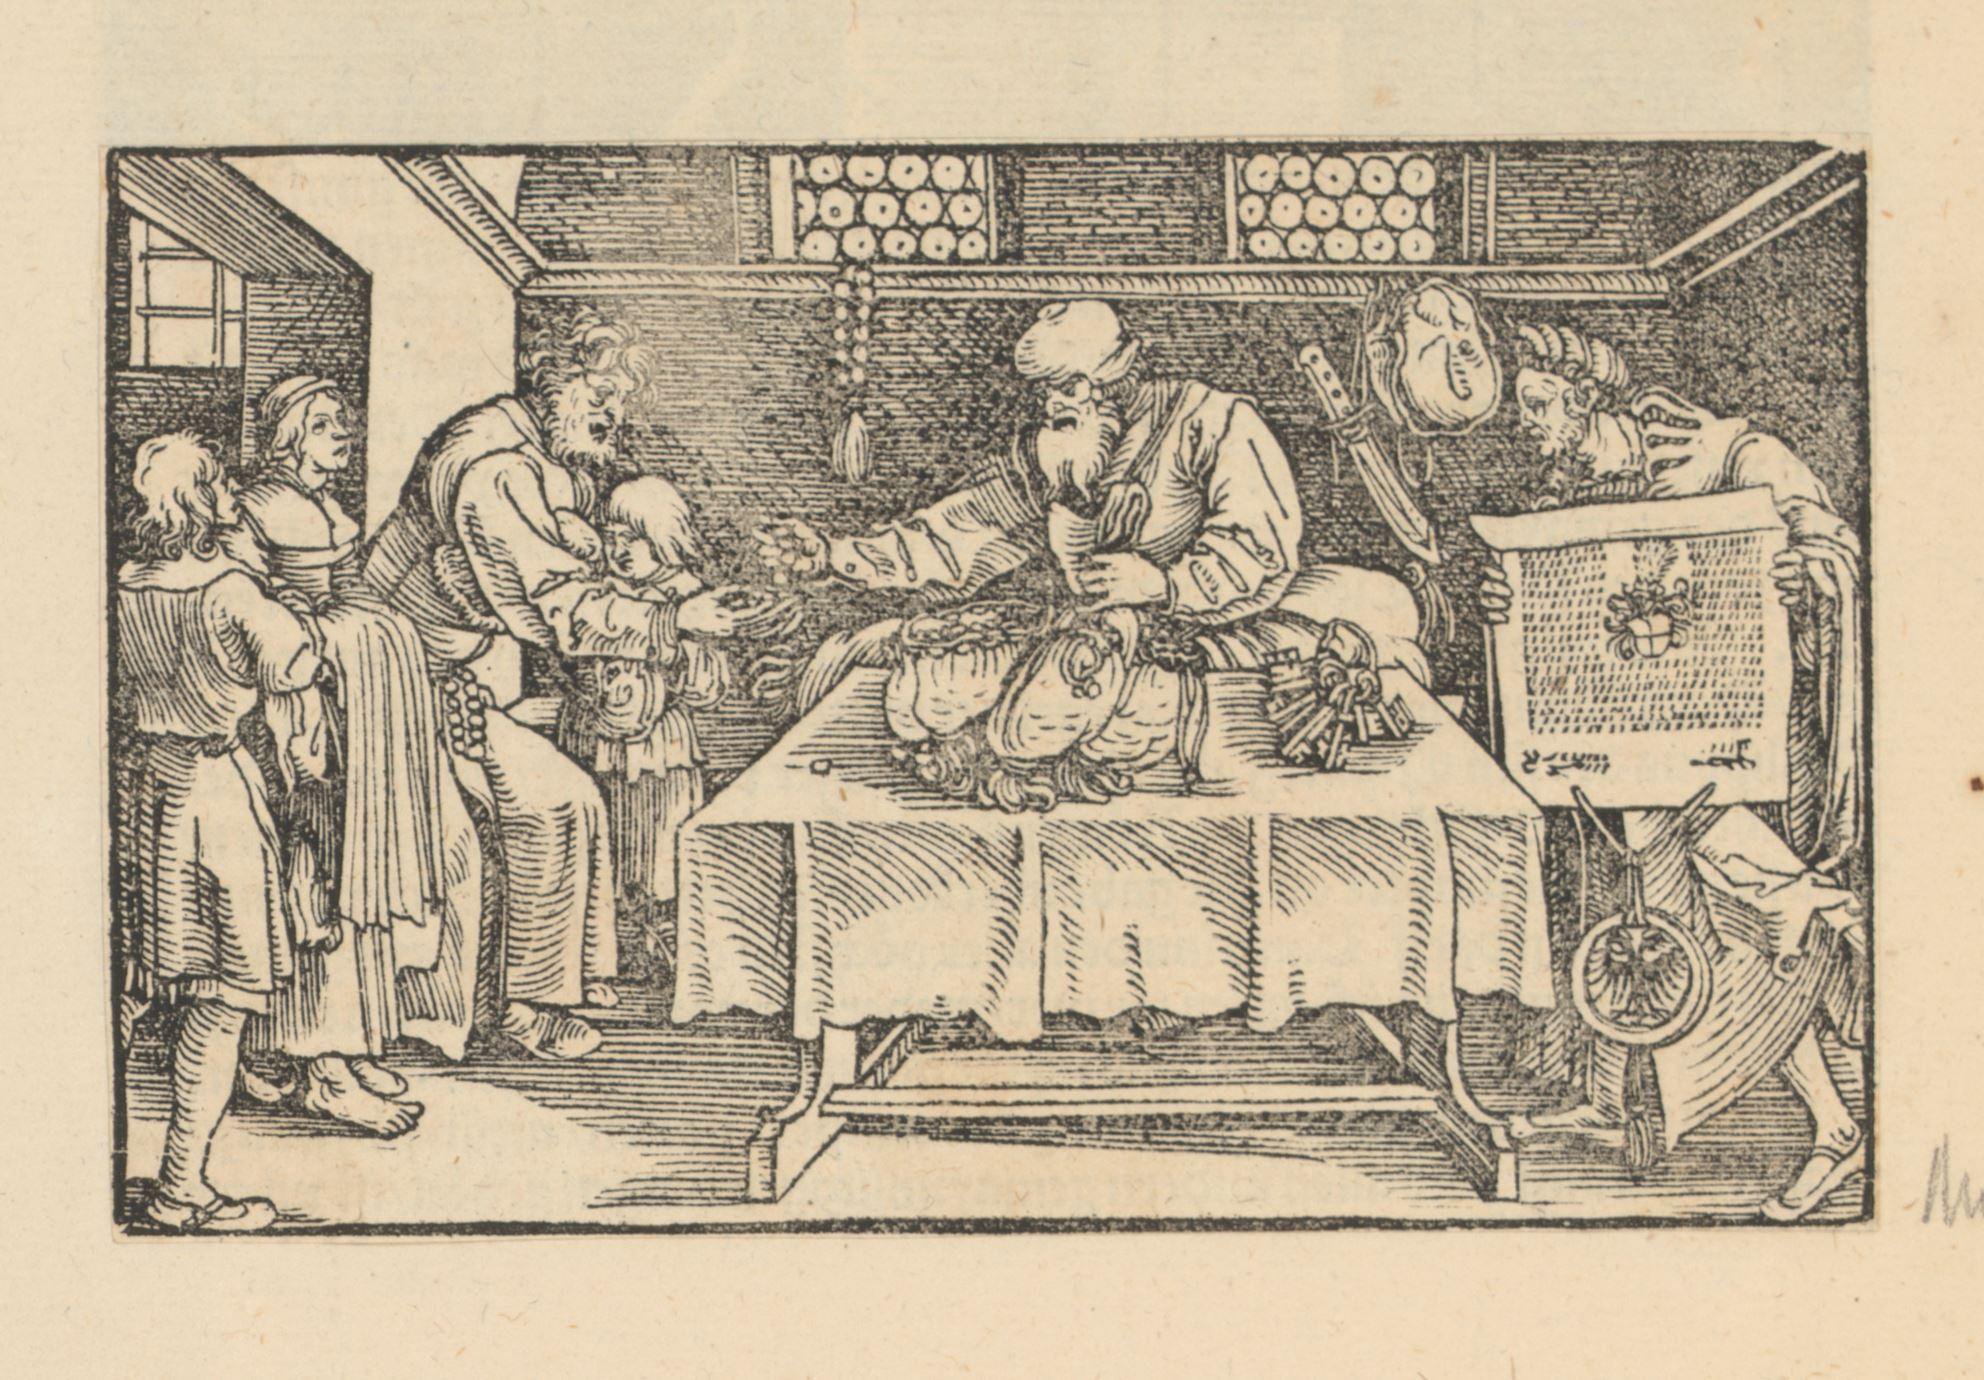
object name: print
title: Man met kinderen ontvangt geld terwijl een man een decreet omhoog houdt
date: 1514-1531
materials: paper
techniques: letterpress printing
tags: sealing wax, parents with their children, money-lender, usurer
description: Deze prent is gebruikt in: Cicero, Marcus Tulius. Officia M.T.C. Ein Buch so Marcus Tullius Cicero der Römer zu seynem (...). [Vertaald uit het Latijn door] Johann von Schwarzenberg. Augsburg: Heinrich Steiner, 1531.